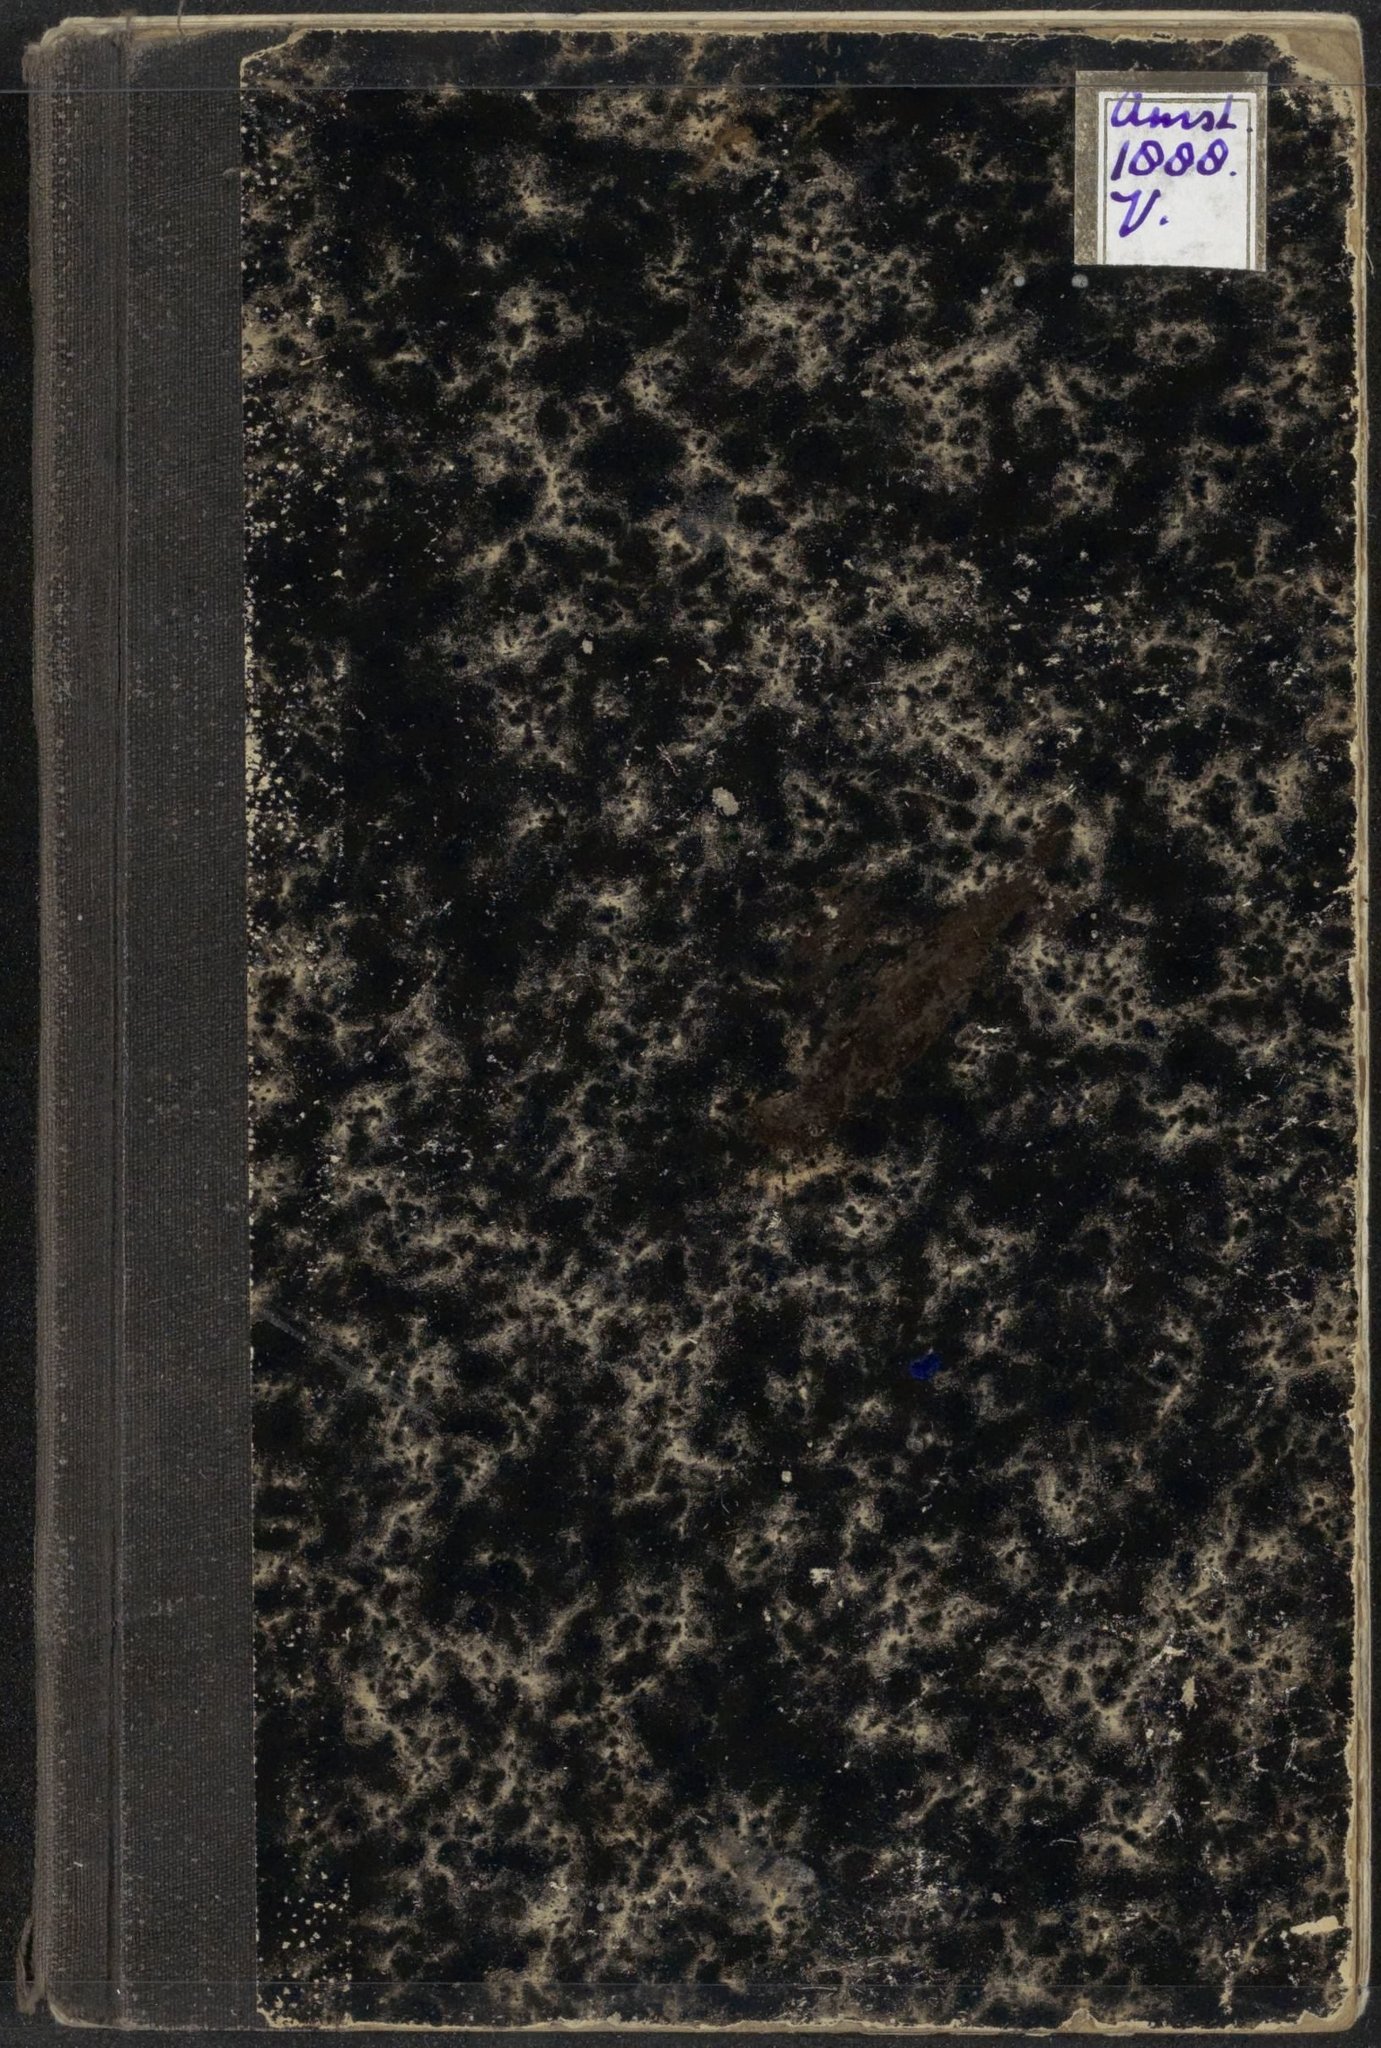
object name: sketchbook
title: Schetsboek met 6 bladen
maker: george hendrik breitner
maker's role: draughtsman, painter, print maker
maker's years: 1857-1923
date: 1888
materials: cardboard, chalk, linen, paper, pencil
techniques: marbling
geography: amsterdam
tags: street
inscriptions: annotation: ‘2 geteekend/ Amsterdam/ Landschap met koeien/ Amst./ 1888./ V.’, workshop stamp: Lugt 291d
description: Schetsboek bestaande uit 6 bladen met stadsgezichten.